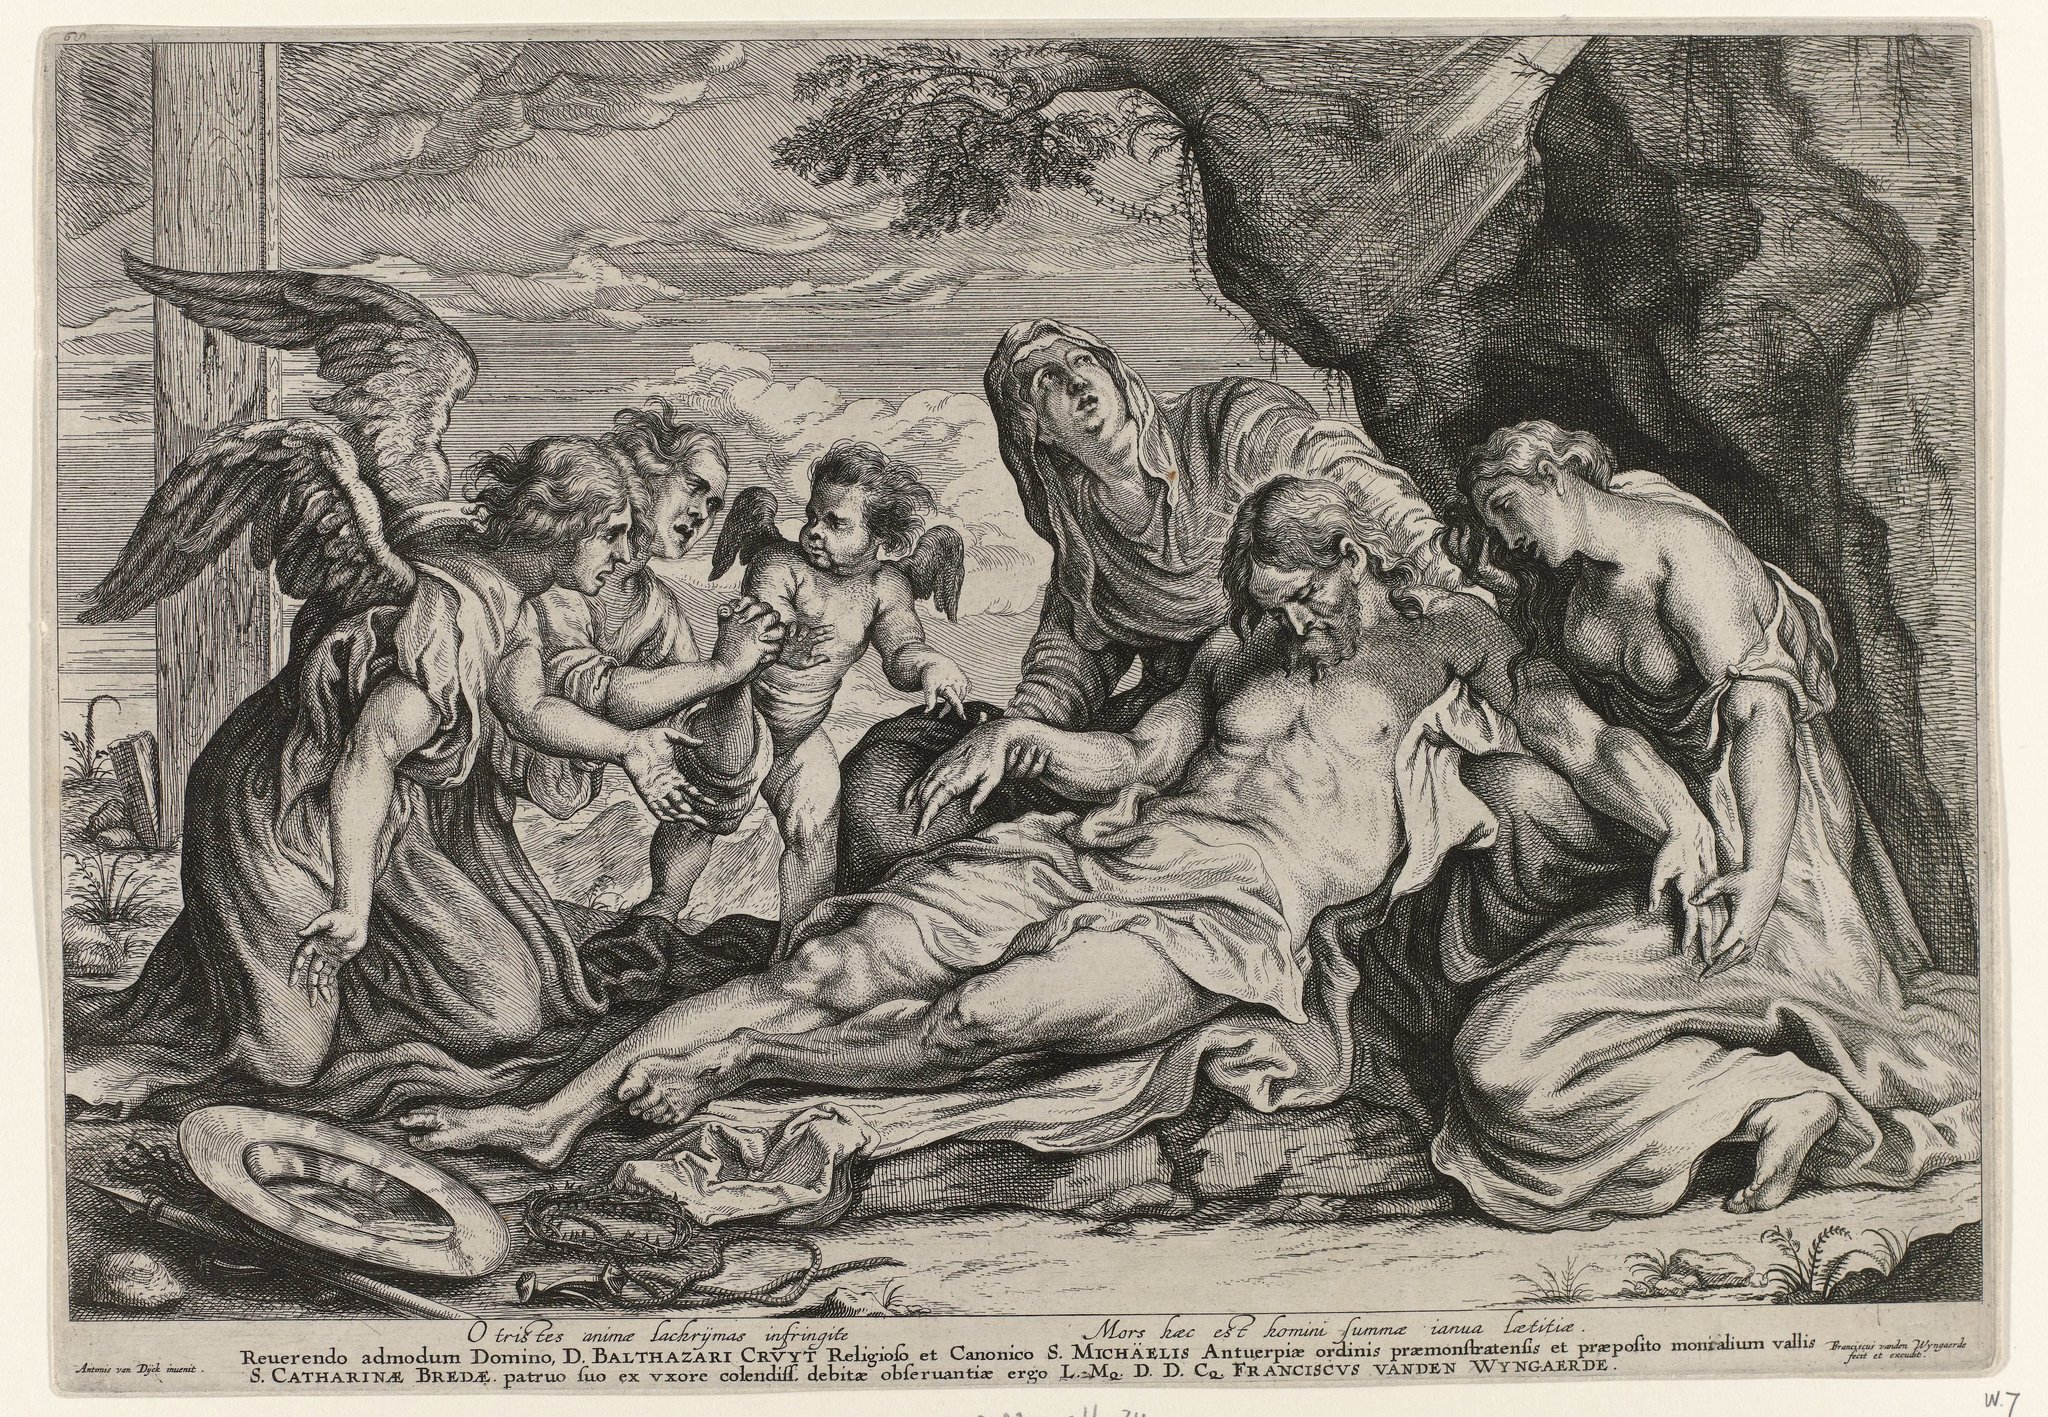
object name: print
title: Bewening van Christus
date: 1636-1679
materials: paper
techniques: engraving, etching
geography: antwerp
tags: christ's body supported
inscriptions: inscription, collector's mark: Lugt 240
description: Engelen treuren bij het lichaam van Christus. Zijn lichaam wordt ondersteund door Maria en Maria Magdalena. Links op de achtergrond is nog de voet van het kruis zichtbaar. In de marge twee regels in het Latijn en een onderschrift met een opdracht in het Latijn.